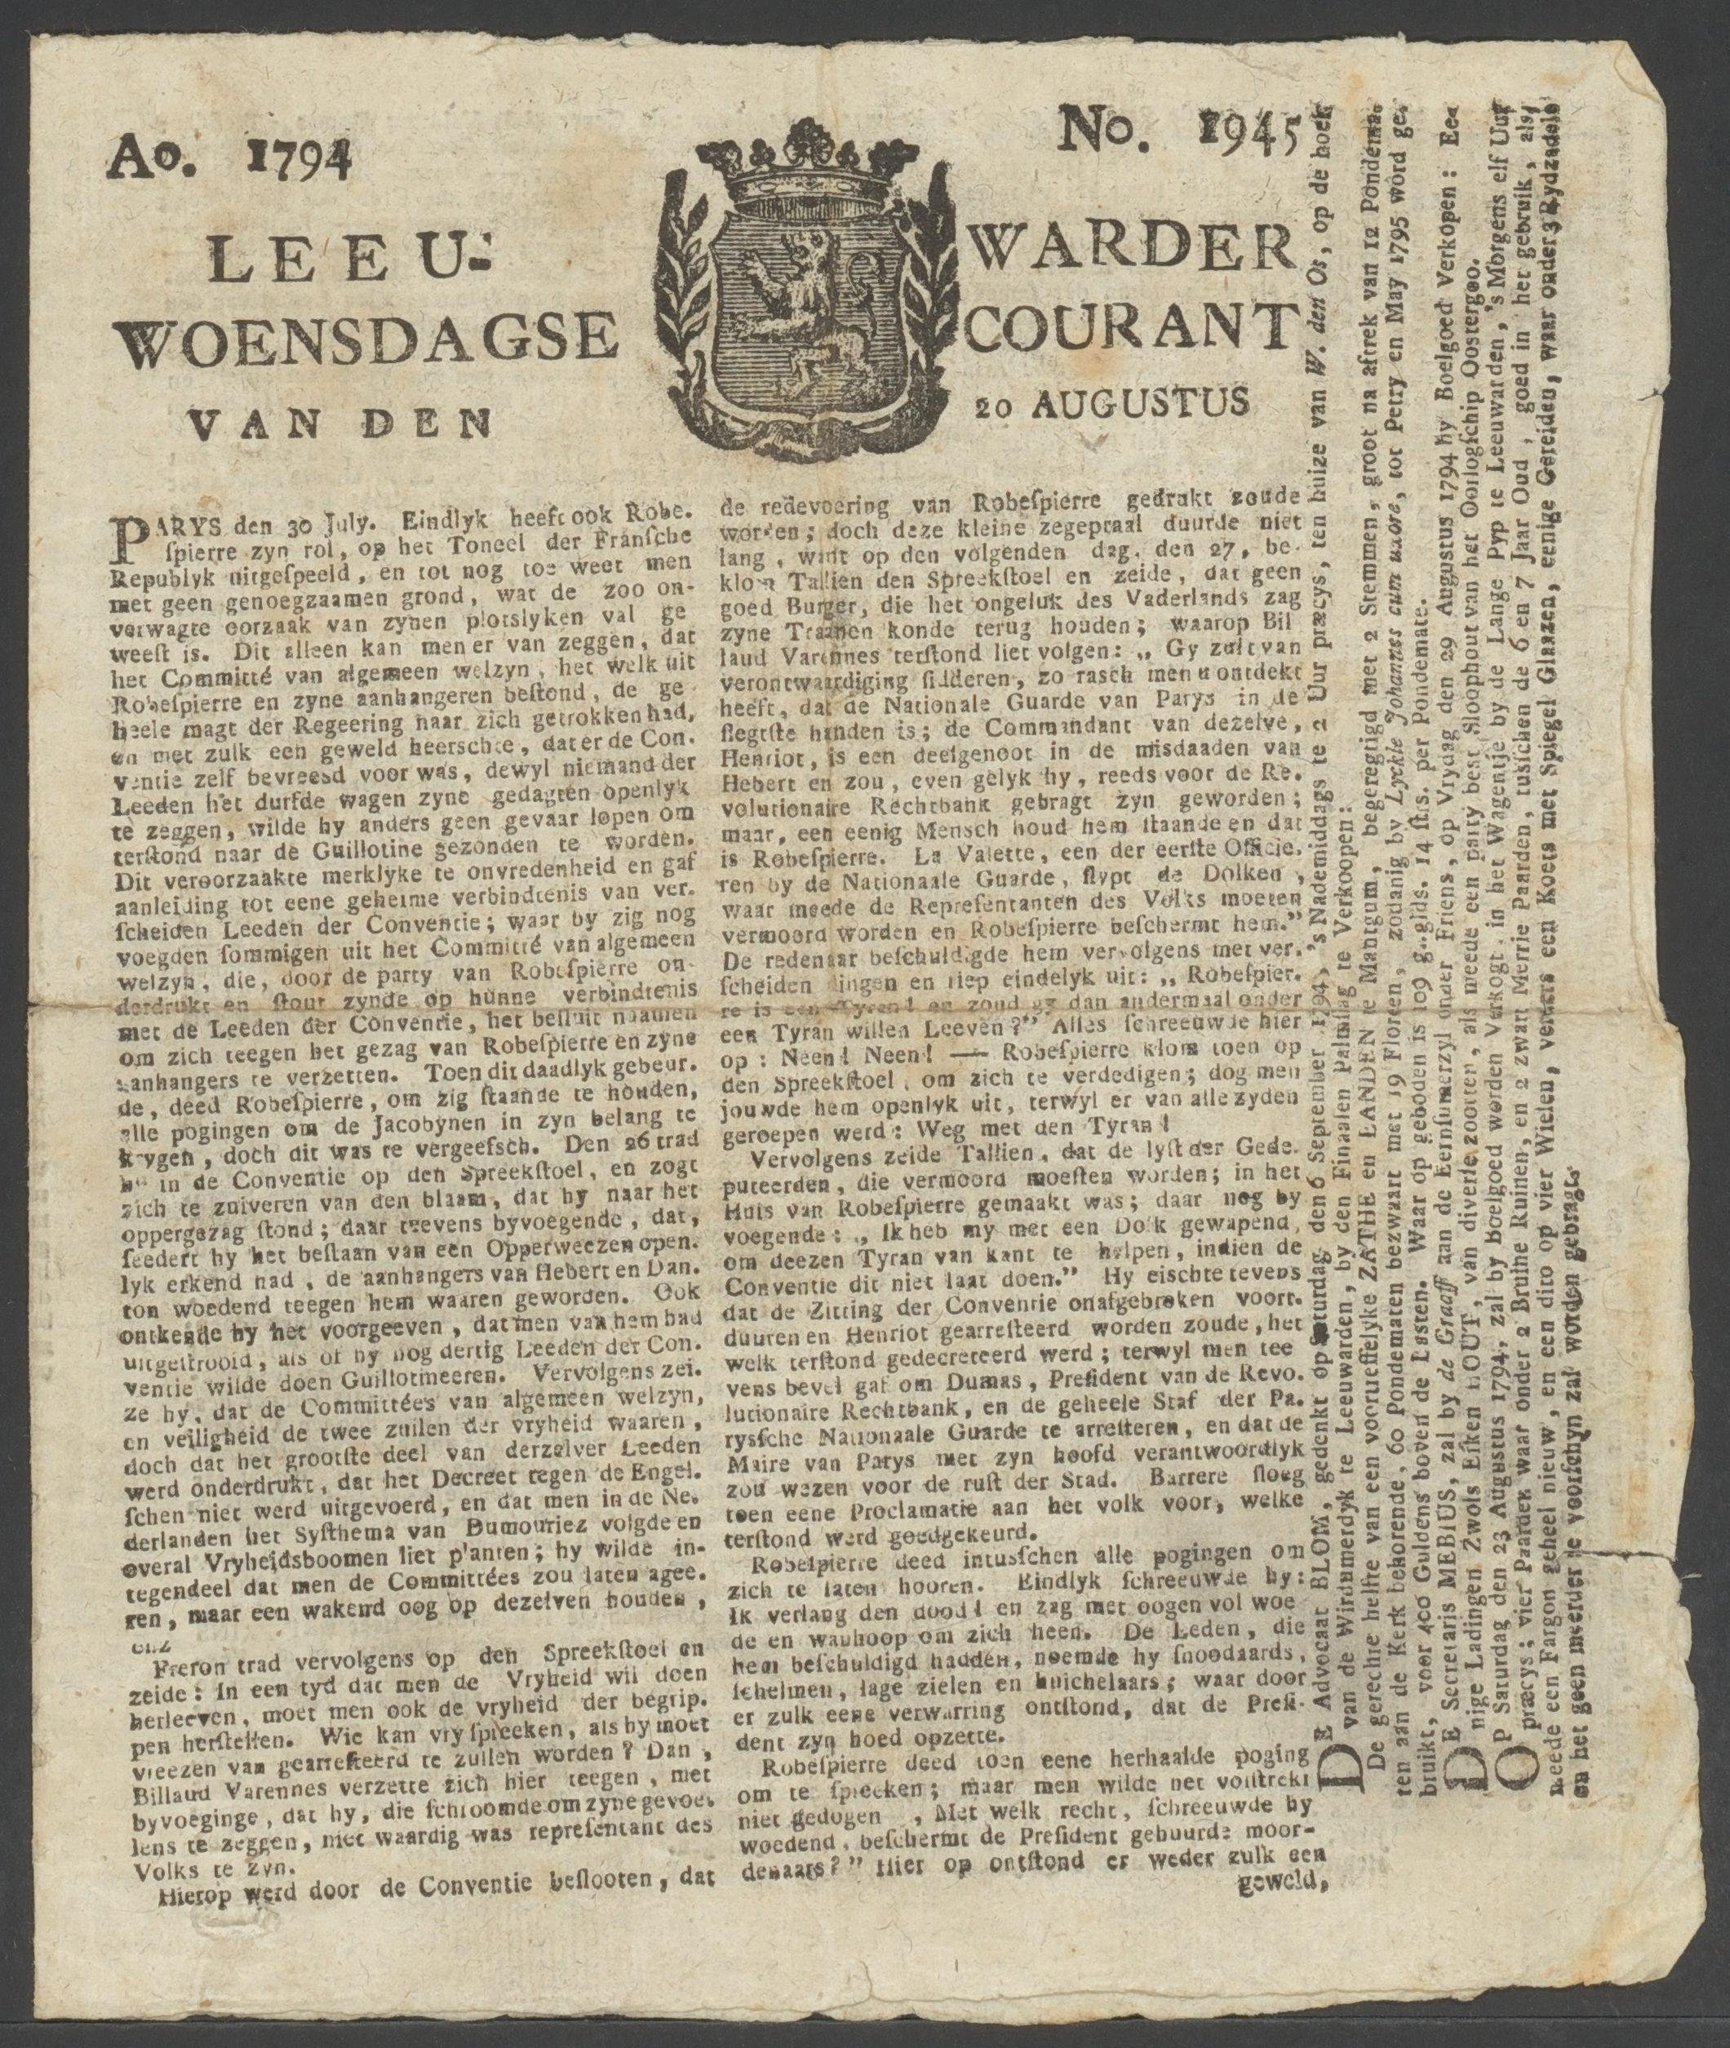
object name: newspaper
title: Leeuwarder Woensdagse Courant, 20 augustus 1794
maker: erven a. ferwerda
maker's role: printer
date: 1794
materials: paper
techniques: letterpress printing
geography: leeuwarden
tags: newspaper, news-sheet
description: Exemplaar van de krant 'Leeuwarder Woensdagse Courant', 20 augustus 1794. Dubbelbladig, alle zijden bedrukt. Bovenaan een vignet met het stadswapen. Onderwerpsrubrieken binnen de Atlas Zeden en Gewoonten: Regeering, Officieele Nieuwsbladen.